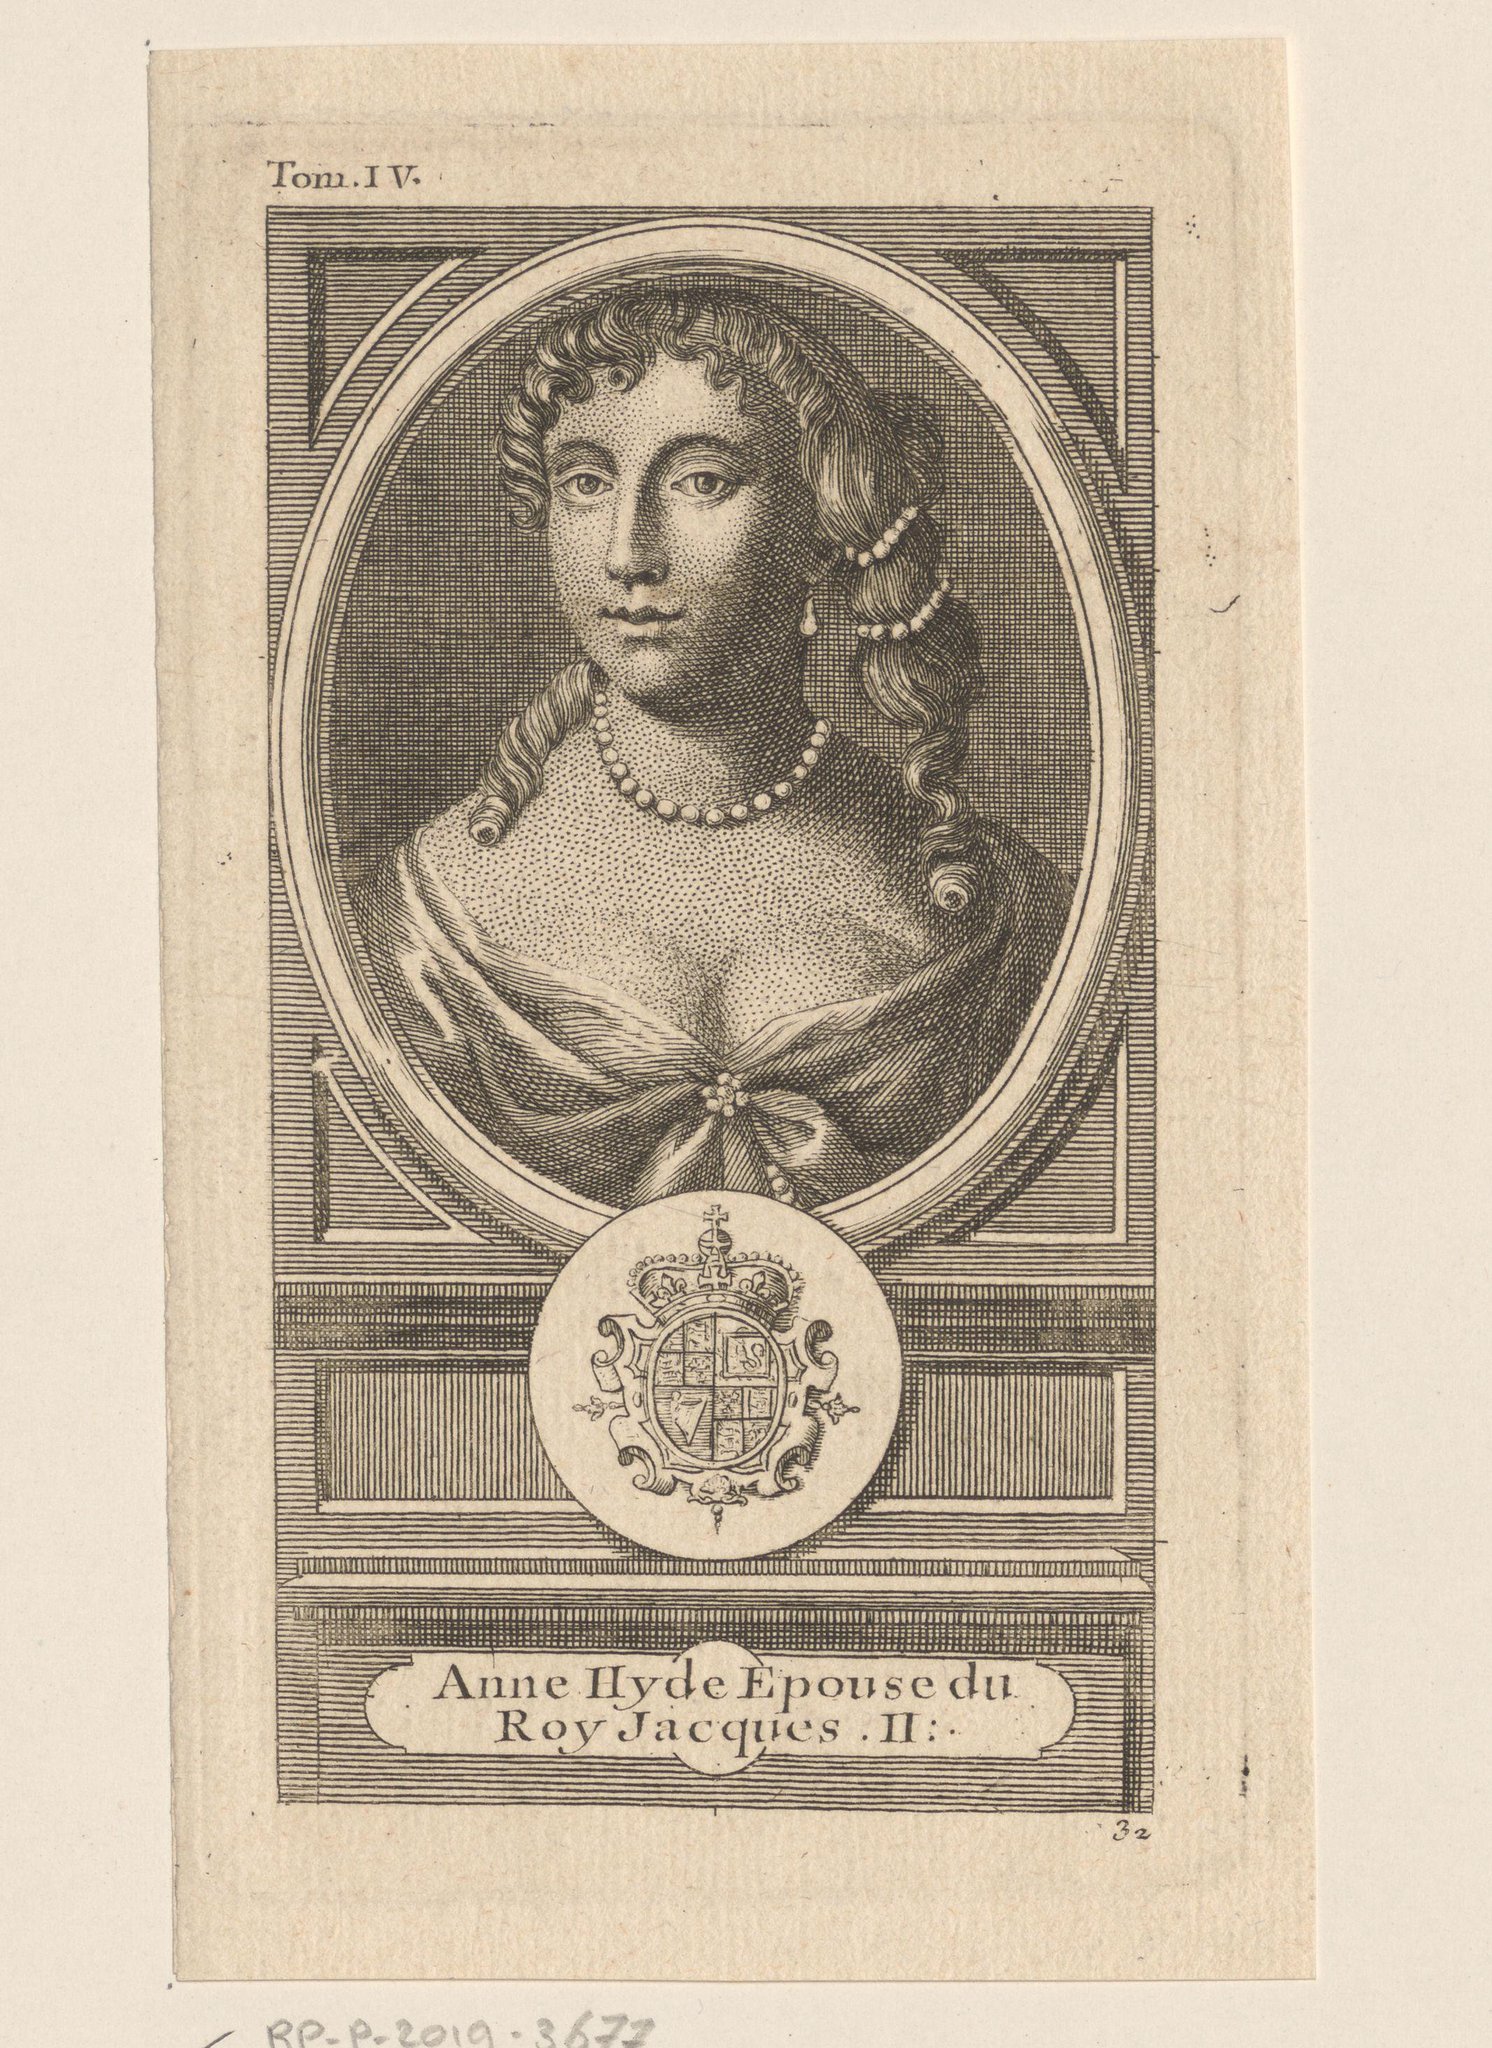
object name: book illustration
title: Portret van Anna Hyde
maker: Anonymous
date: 1660-1699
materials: paper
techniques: engraving, etching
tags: historical persons - bb - woman, armorial bearing, heraldry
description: Met in het midden haar wapenschild. Linksboven genummerd: Tom. IV. Rechtsonder genummerd: 32.